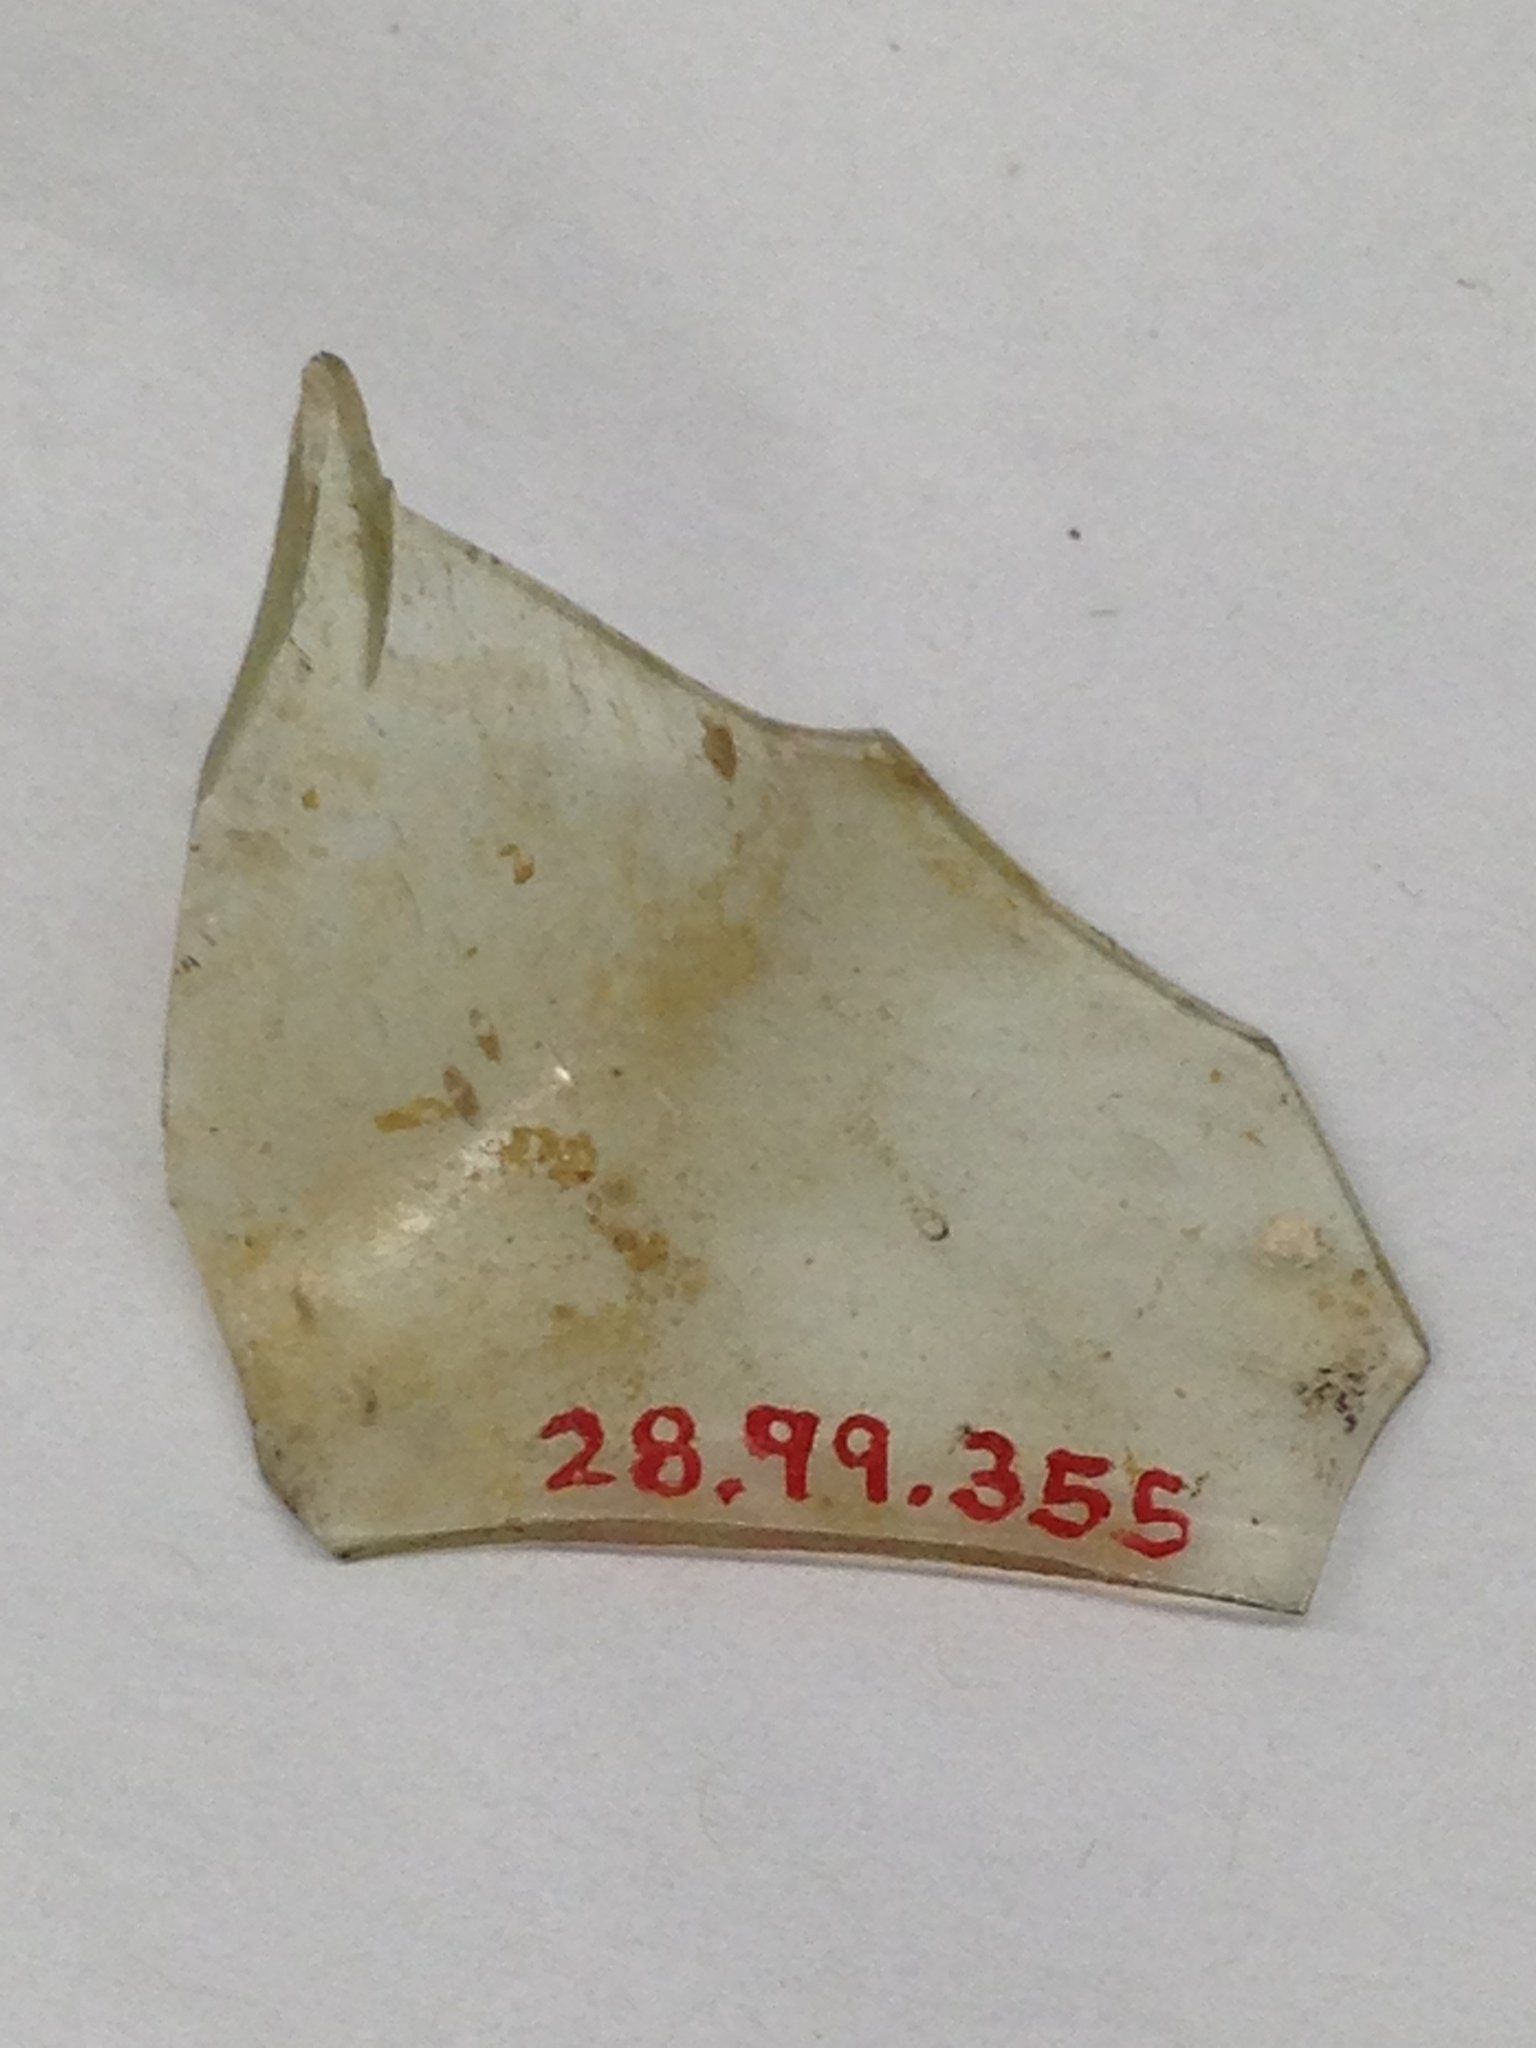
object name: fragment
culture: european or middle eastern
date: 1150-1250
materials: ceramic, glass